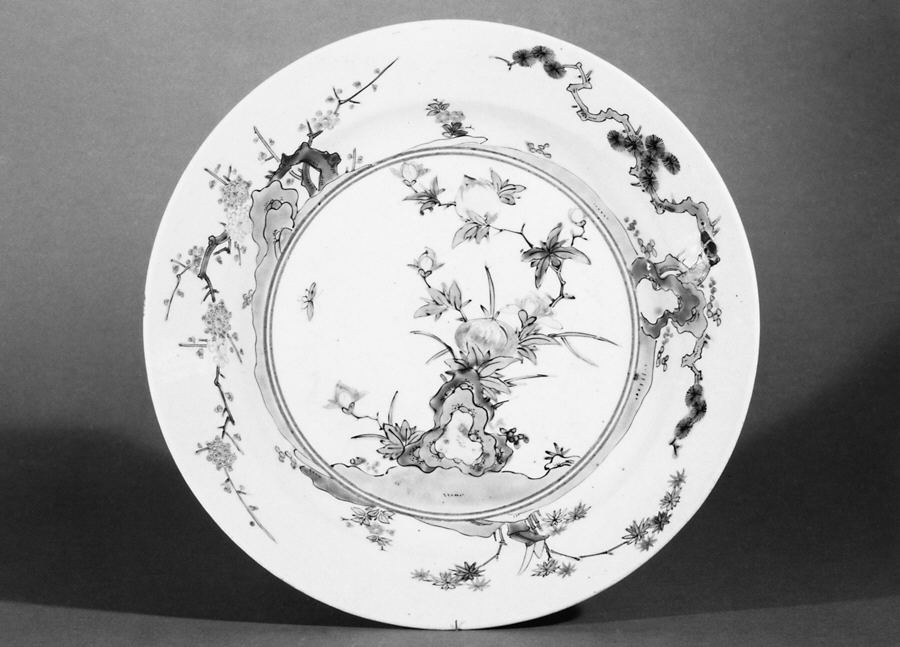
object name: plate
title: Plate with Flower and Bird Decor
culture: japanese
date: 1680-1700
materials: enamel, porcelain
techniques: overglaze, painting, polychrome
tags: birds,flowers